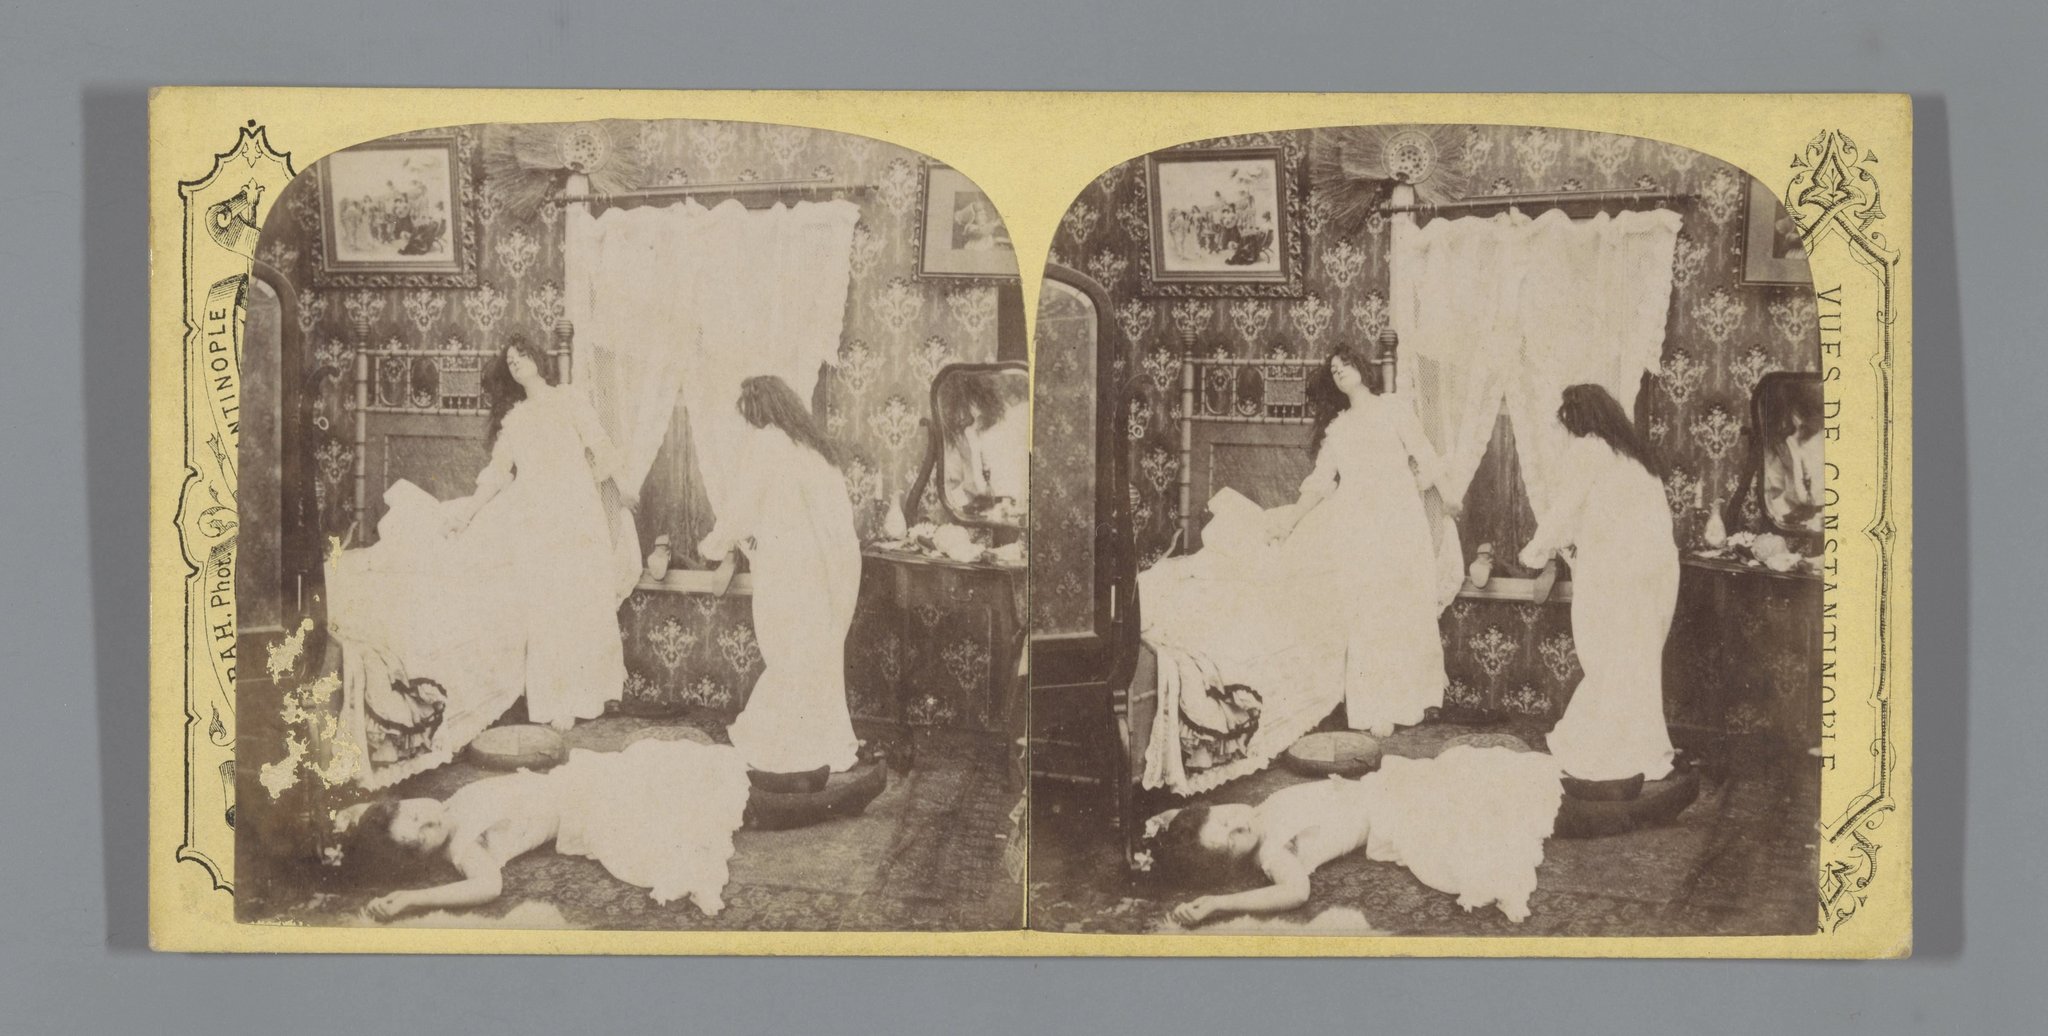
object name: stereograph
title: Drie jonge vrouwen in nachtgewaad in slaapkamer met twee mannenschoenen die uit open raam steken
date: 1890-1900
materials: cardboard, photographic support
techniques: albumen print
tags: bedroom, underclothes and nightwear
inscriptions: : ‘Vues de Constantinople’